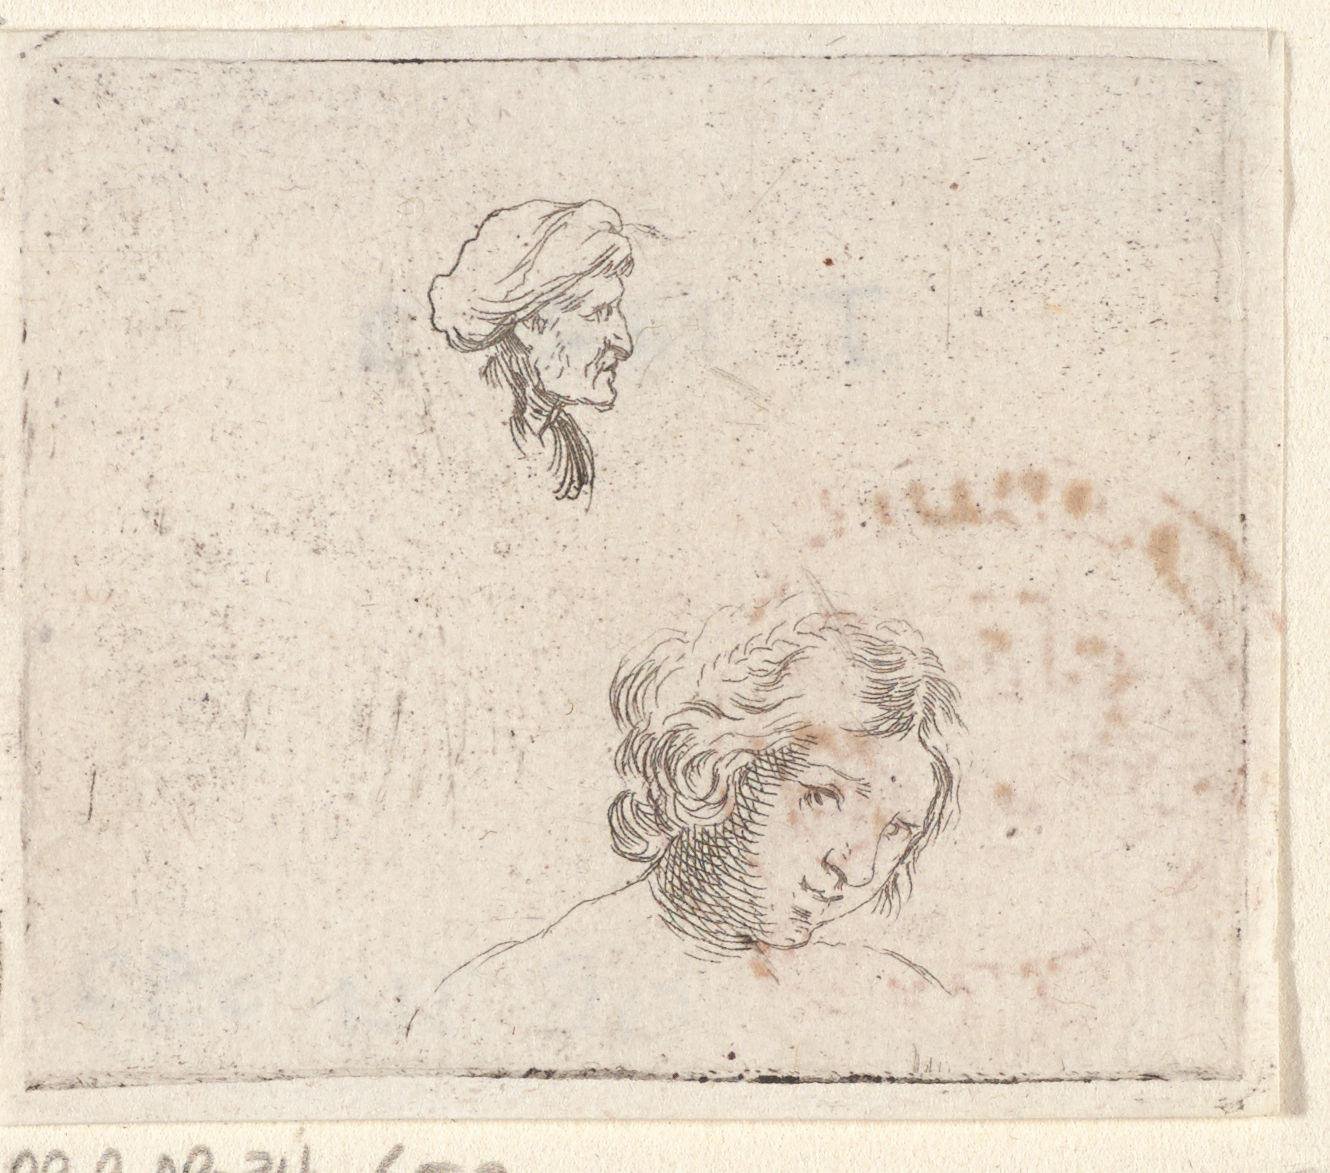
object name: print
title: Hoofden van een oude en van een jonge vrouw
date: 1620-1664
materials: paper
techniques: etching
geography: paris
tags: adult woman, head (human) (+ sideview, profile), old woman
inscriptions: collector's mark: Lugt 240